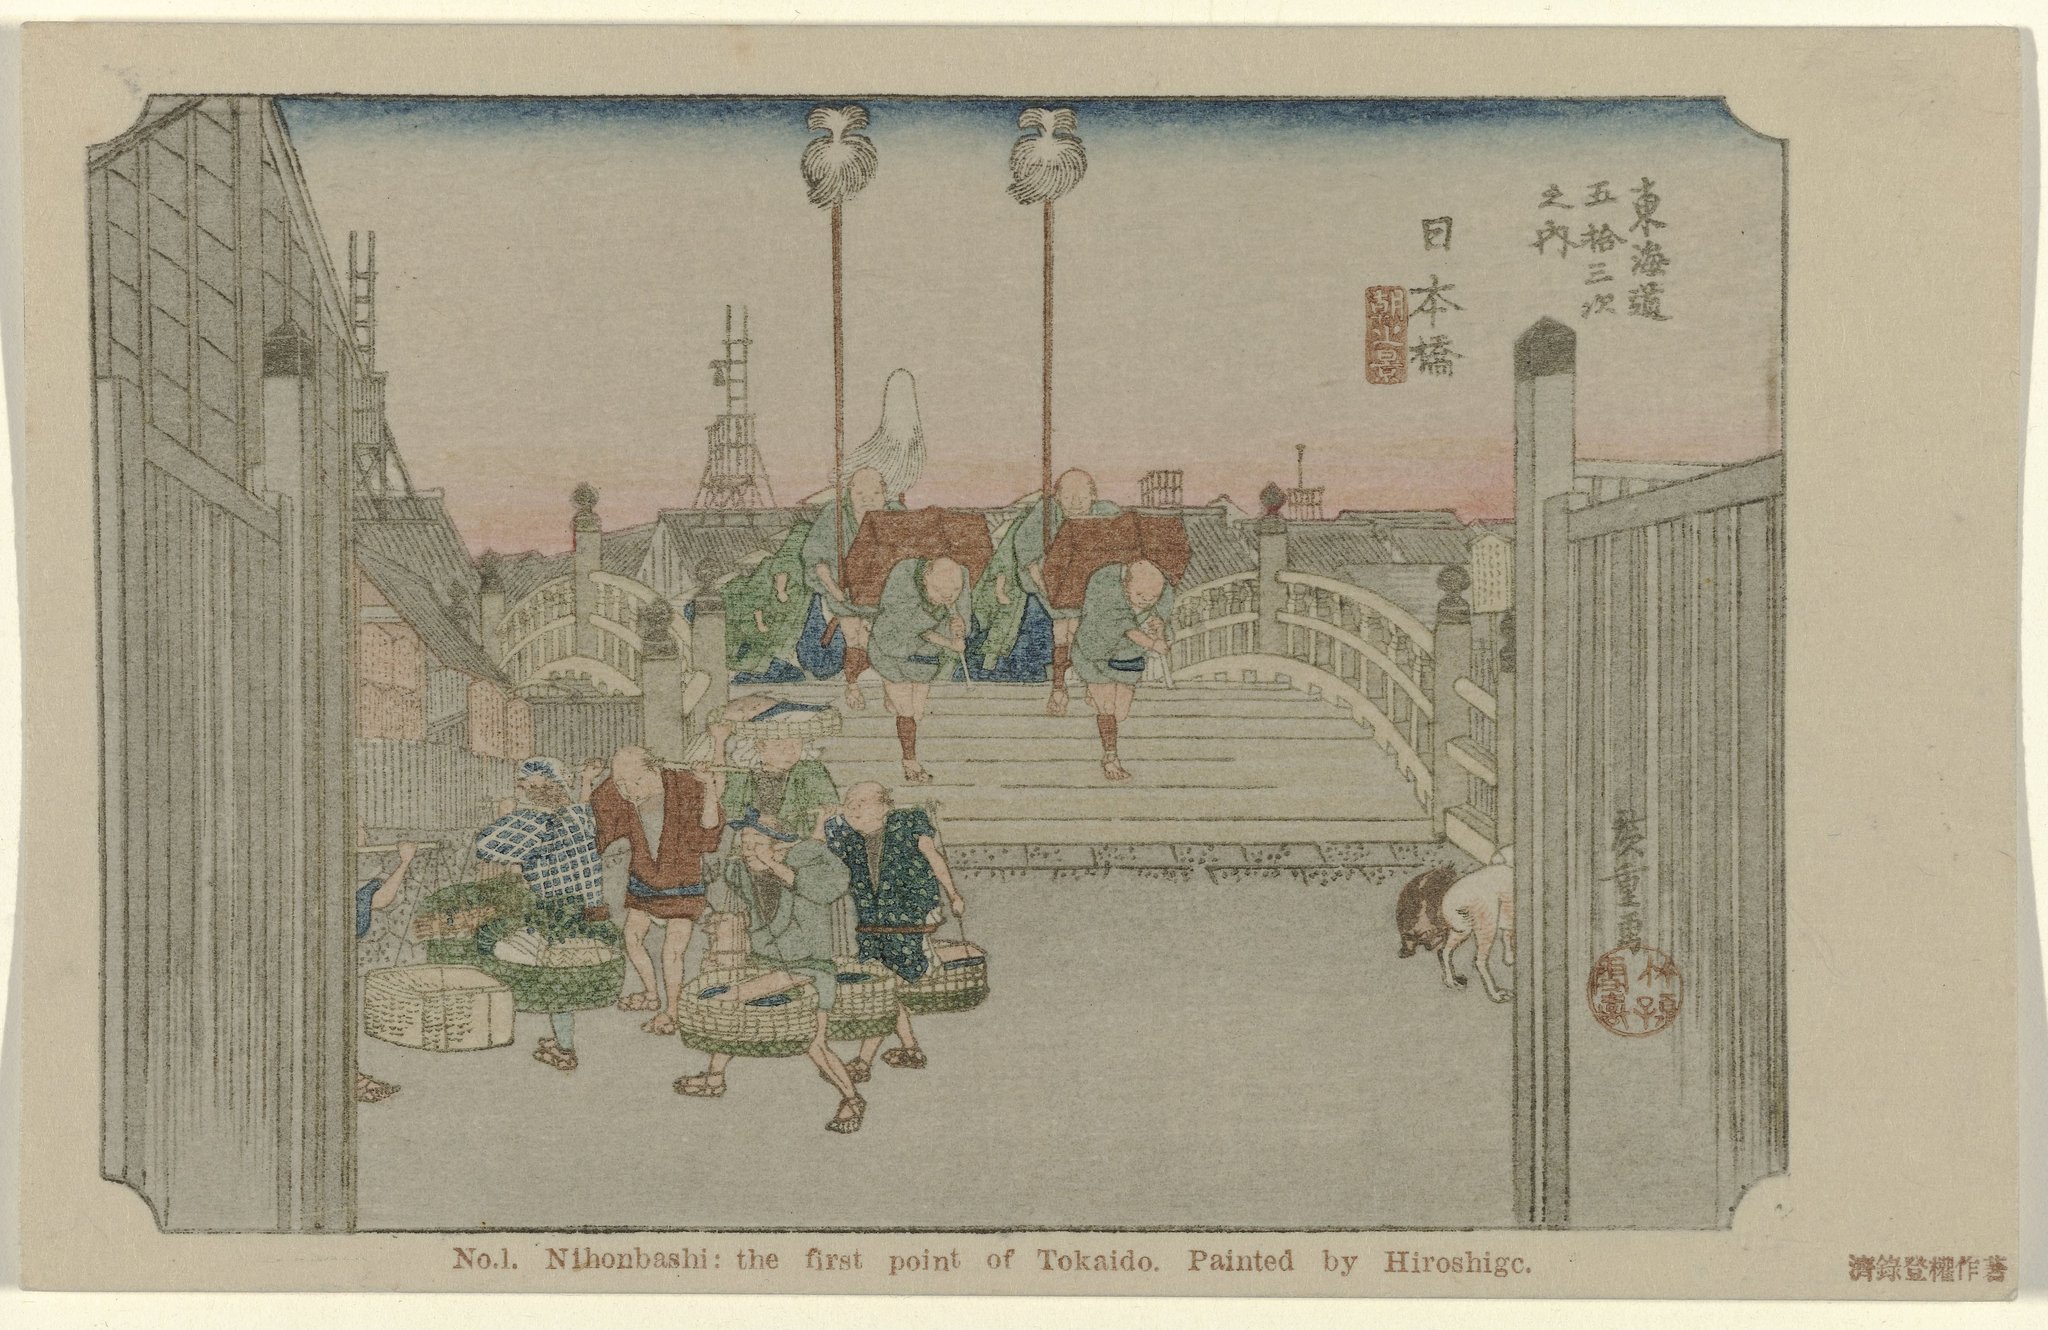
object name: ansichtkaart, prentbriefkaart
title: Nihonbashi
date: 1906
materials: cardboard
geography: japan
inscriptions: date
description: De brug Nihonbashi in Tokyo met kooplui die hun waren dragen.